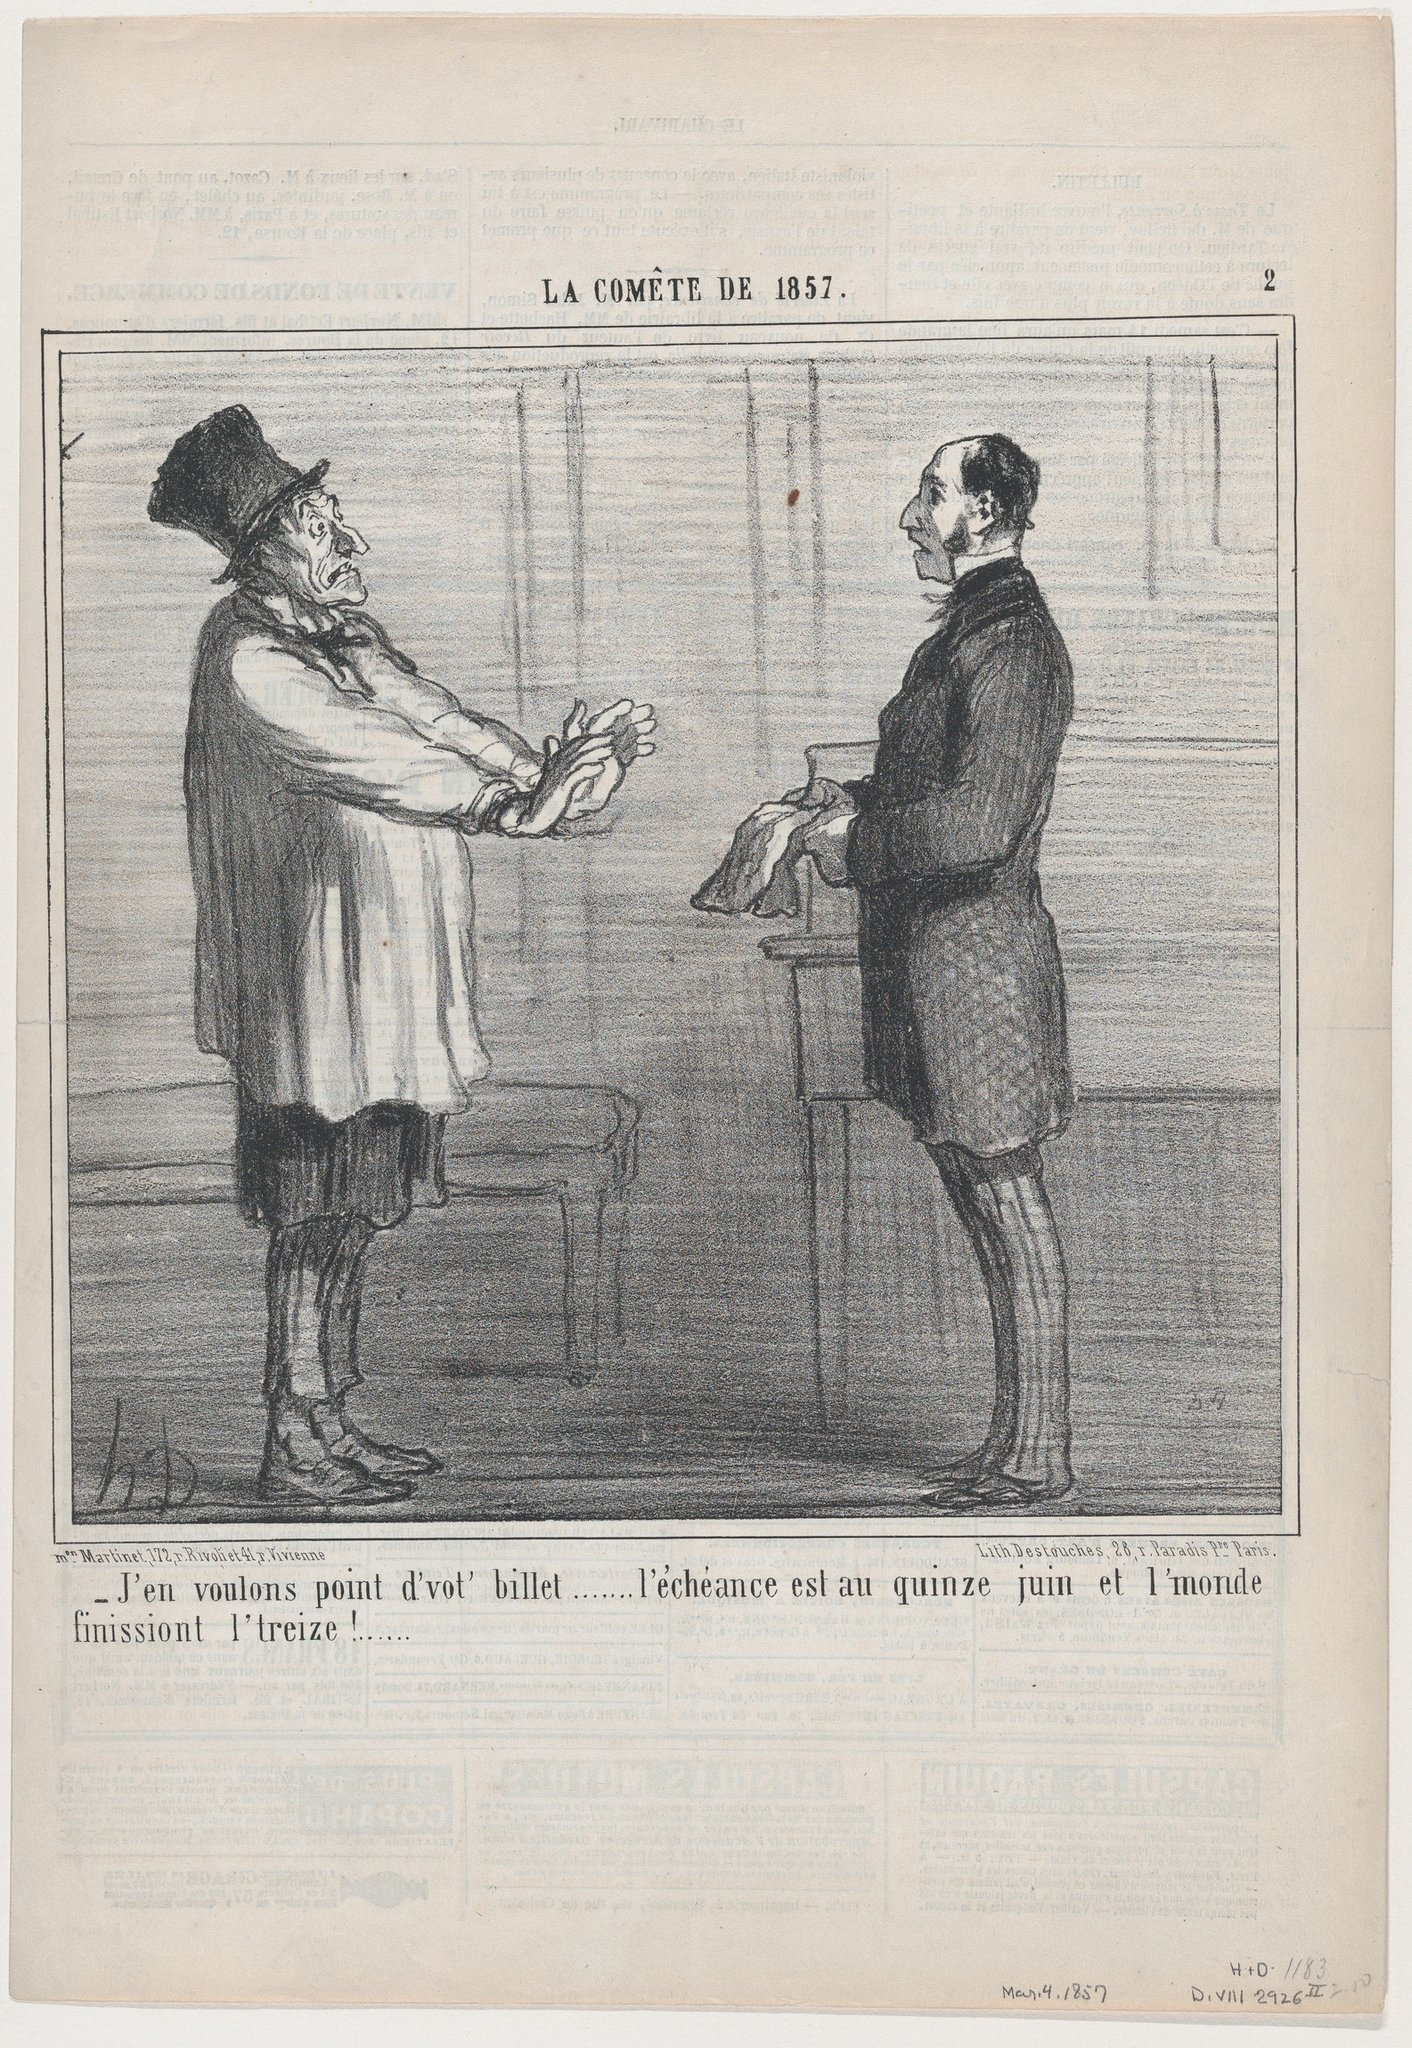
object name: print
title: J'en voilons point d'vot' billet, from "La Comète de 1857"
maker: honoré daumier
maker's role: artist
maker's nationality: french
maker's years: 1808-1879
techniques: lithograph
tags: men,profiles